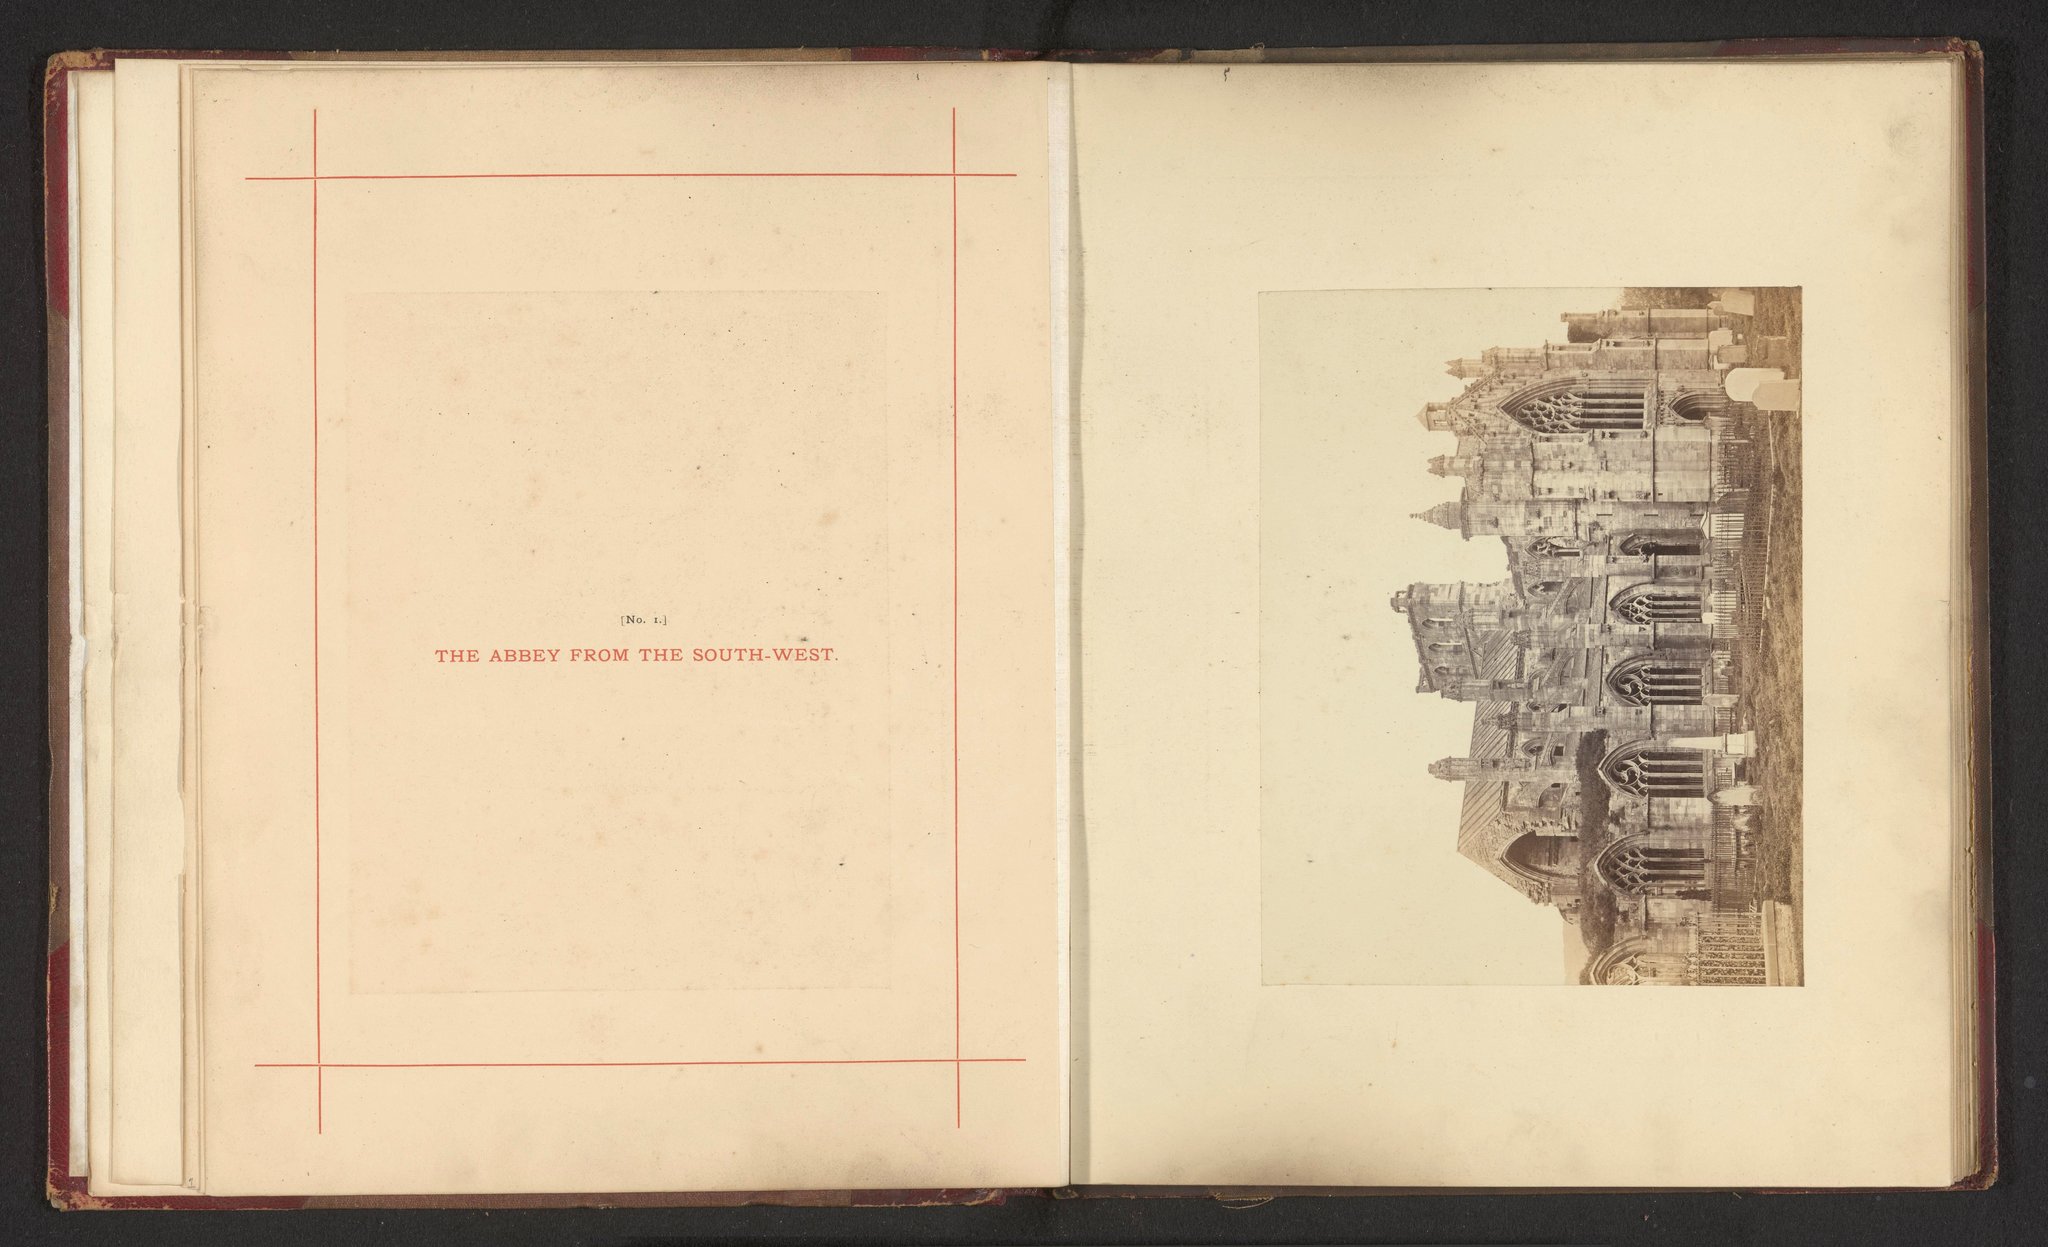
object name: page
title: Gezicht op de ruïne van Melrose Abbey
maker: w.j. pringle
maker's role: fotograaf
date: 1860-1870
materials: photographic support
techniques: albumen print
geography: melrose abbey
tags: ruin of church, monastery, etc.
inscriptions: number: ‘(No. 1.)’, title: ‘The Abbey from the south-west’